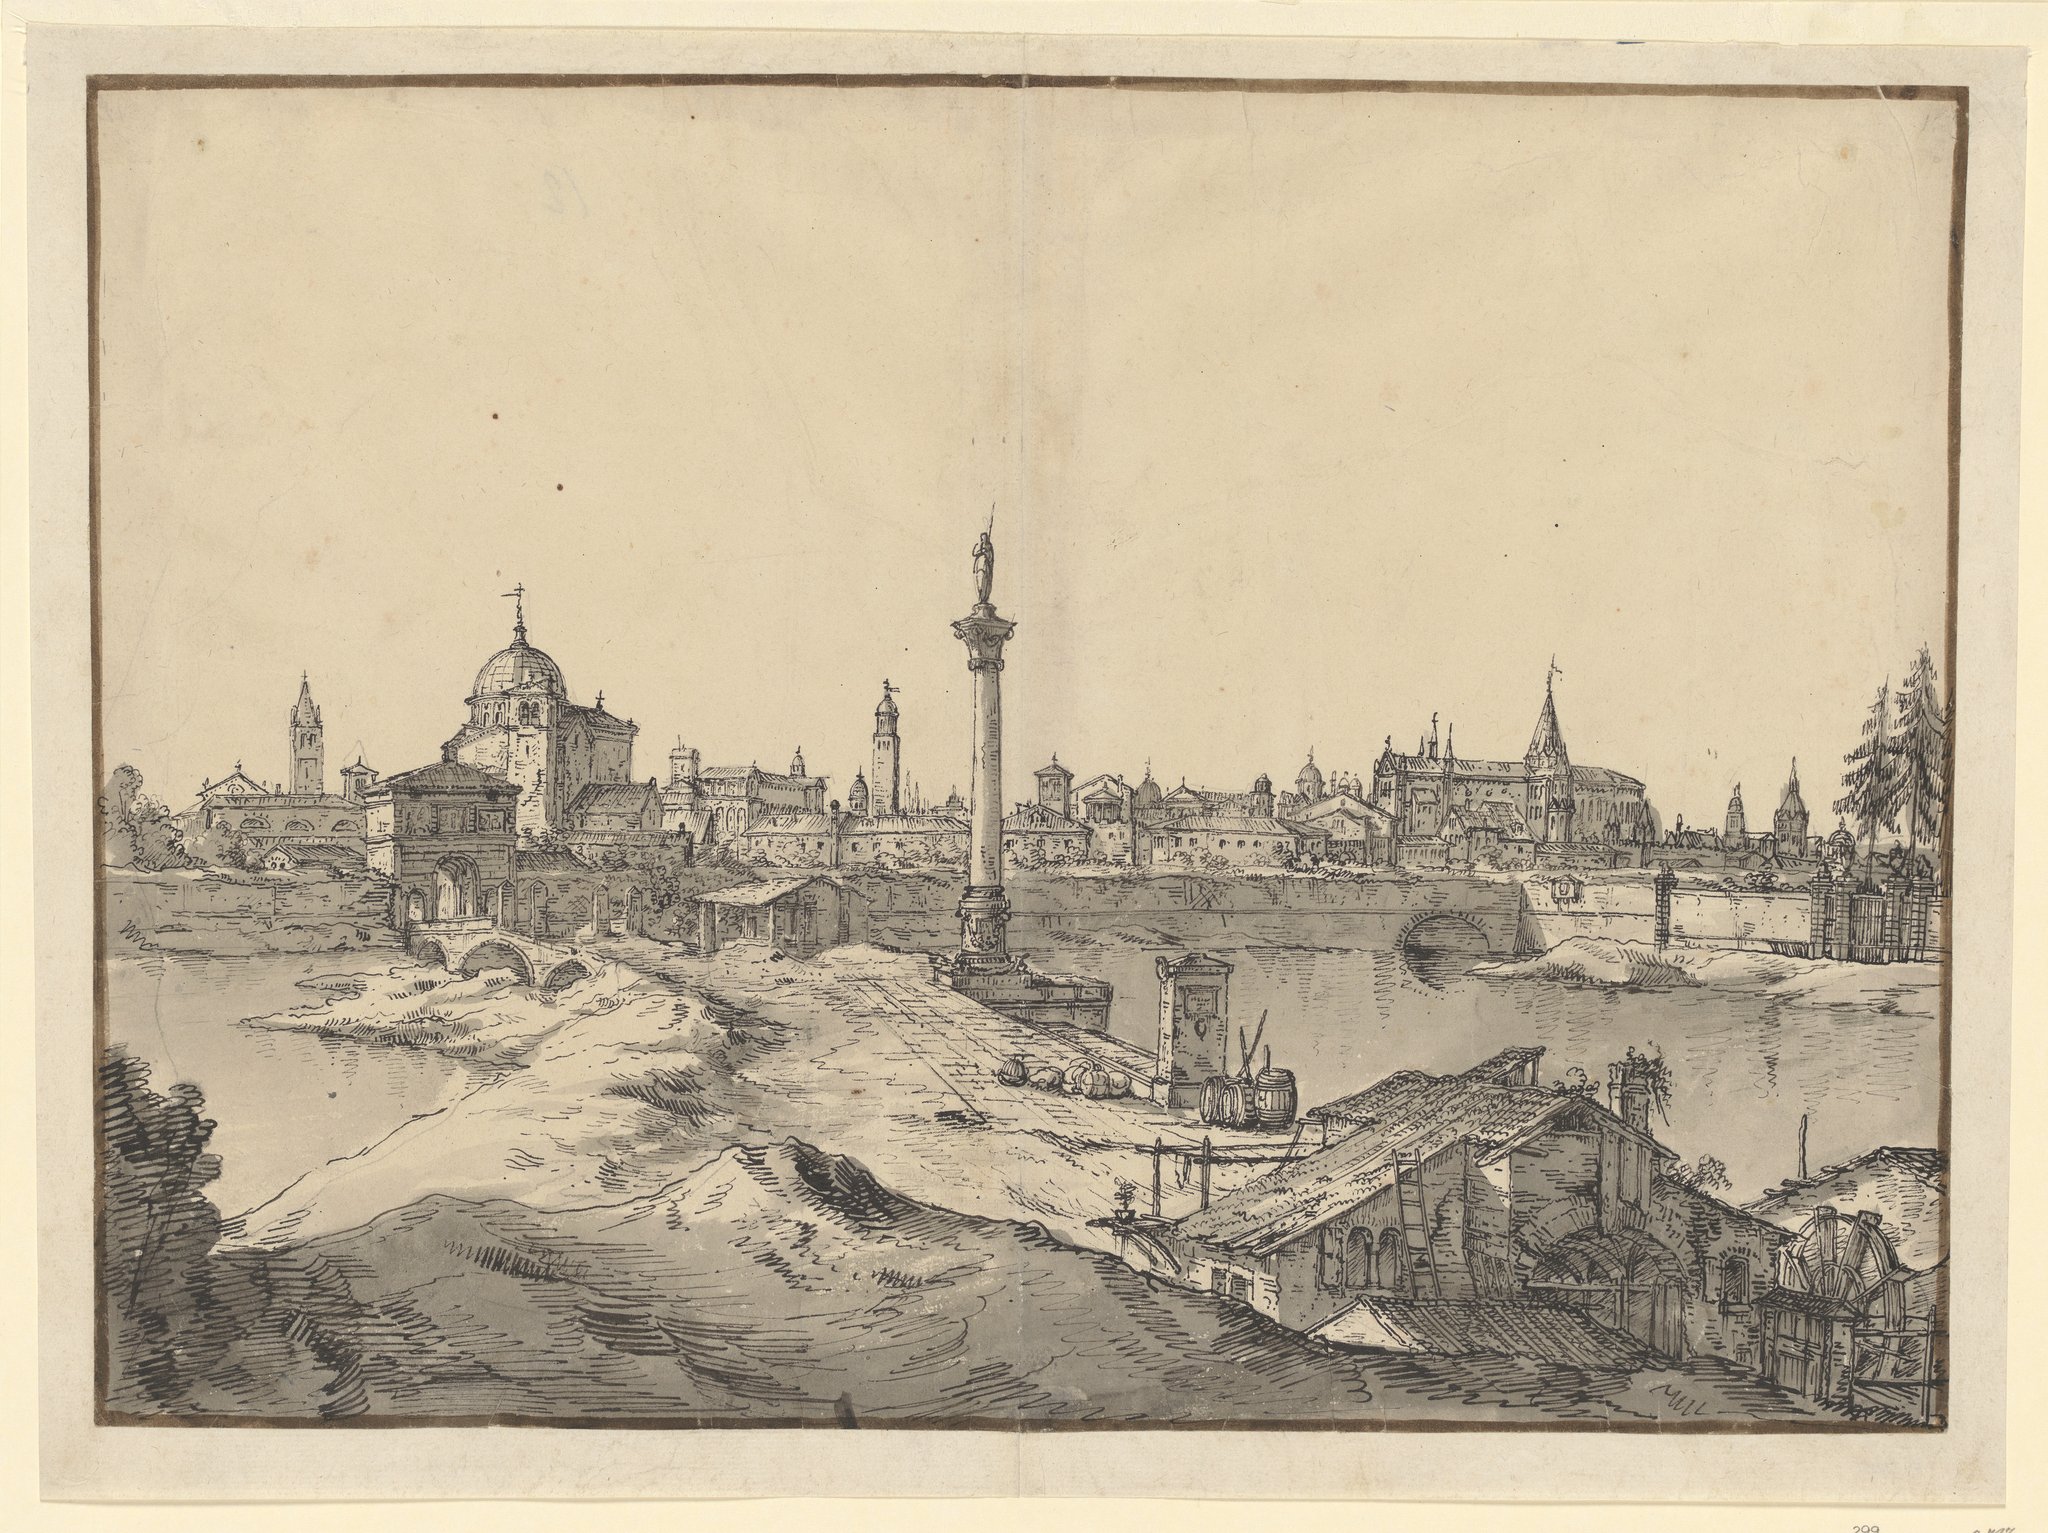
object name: drawing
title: Imaginary View of Padua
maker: bernardo bellotto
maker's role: artist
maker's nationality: italian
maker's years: 1722-1780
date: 1740-1741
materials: ink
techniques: pen, wash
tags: buildings,cities